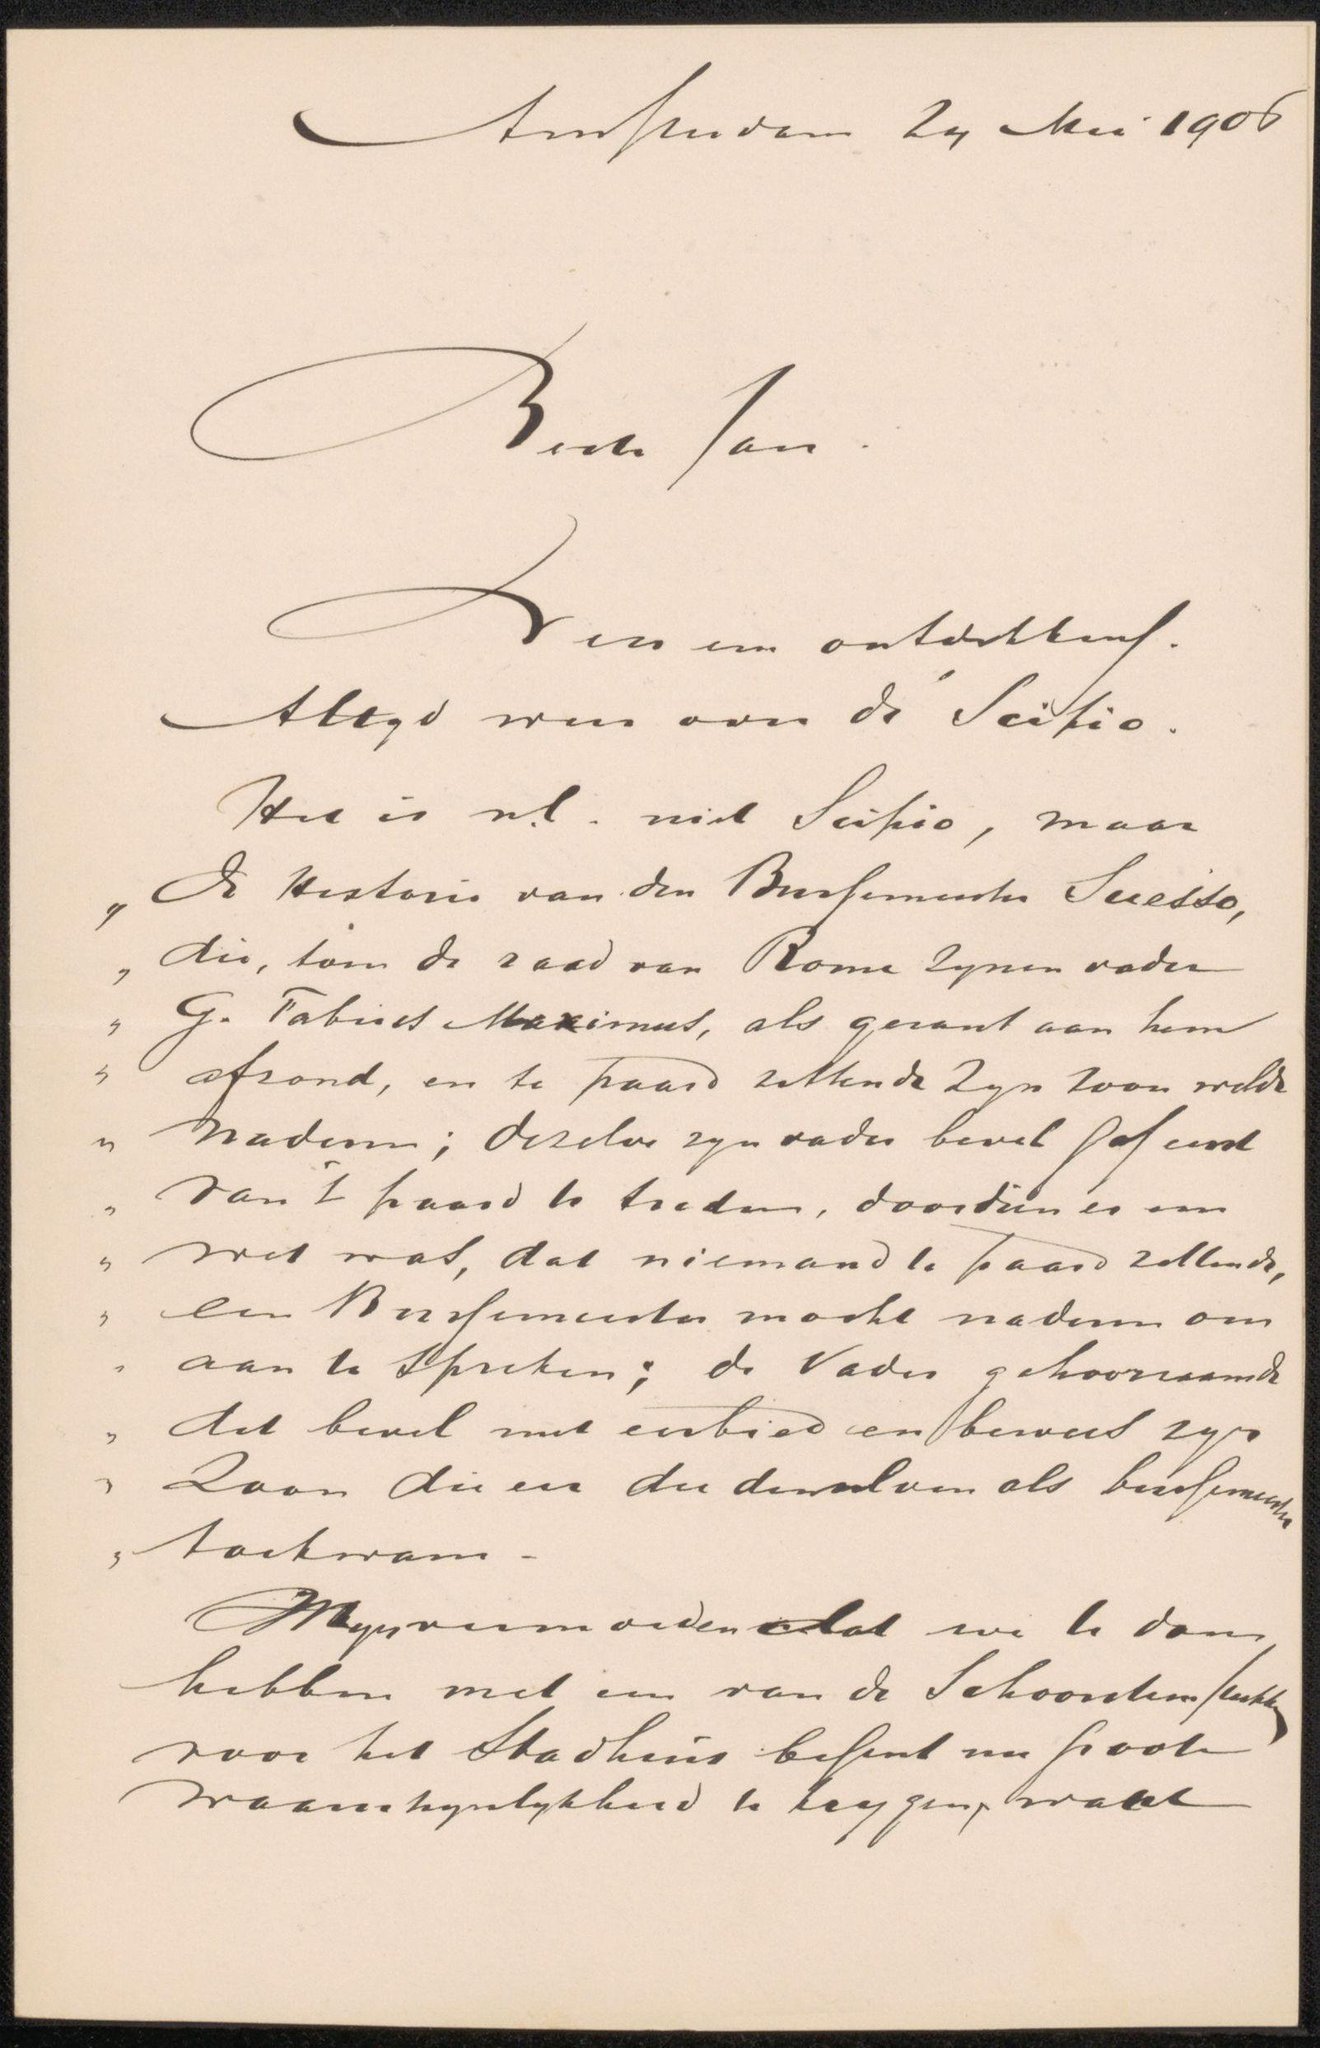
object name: letter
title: Brief aan Jan Veth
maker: cornelis gerardus t hooft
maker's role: draughtsman, painter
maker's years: 1866-1936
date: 1906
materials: ink, paper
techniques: pen, writing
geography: amsterdam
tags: dordrecht, painter, print maker, draughtsman, designer, jan veth, leiden, jan lievens, painting (including book-illumination, miniature-painting), plan ~ architecture, printed matter, royal palace of amsterdam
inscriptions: watermark, collector's mark: ‘RPK’